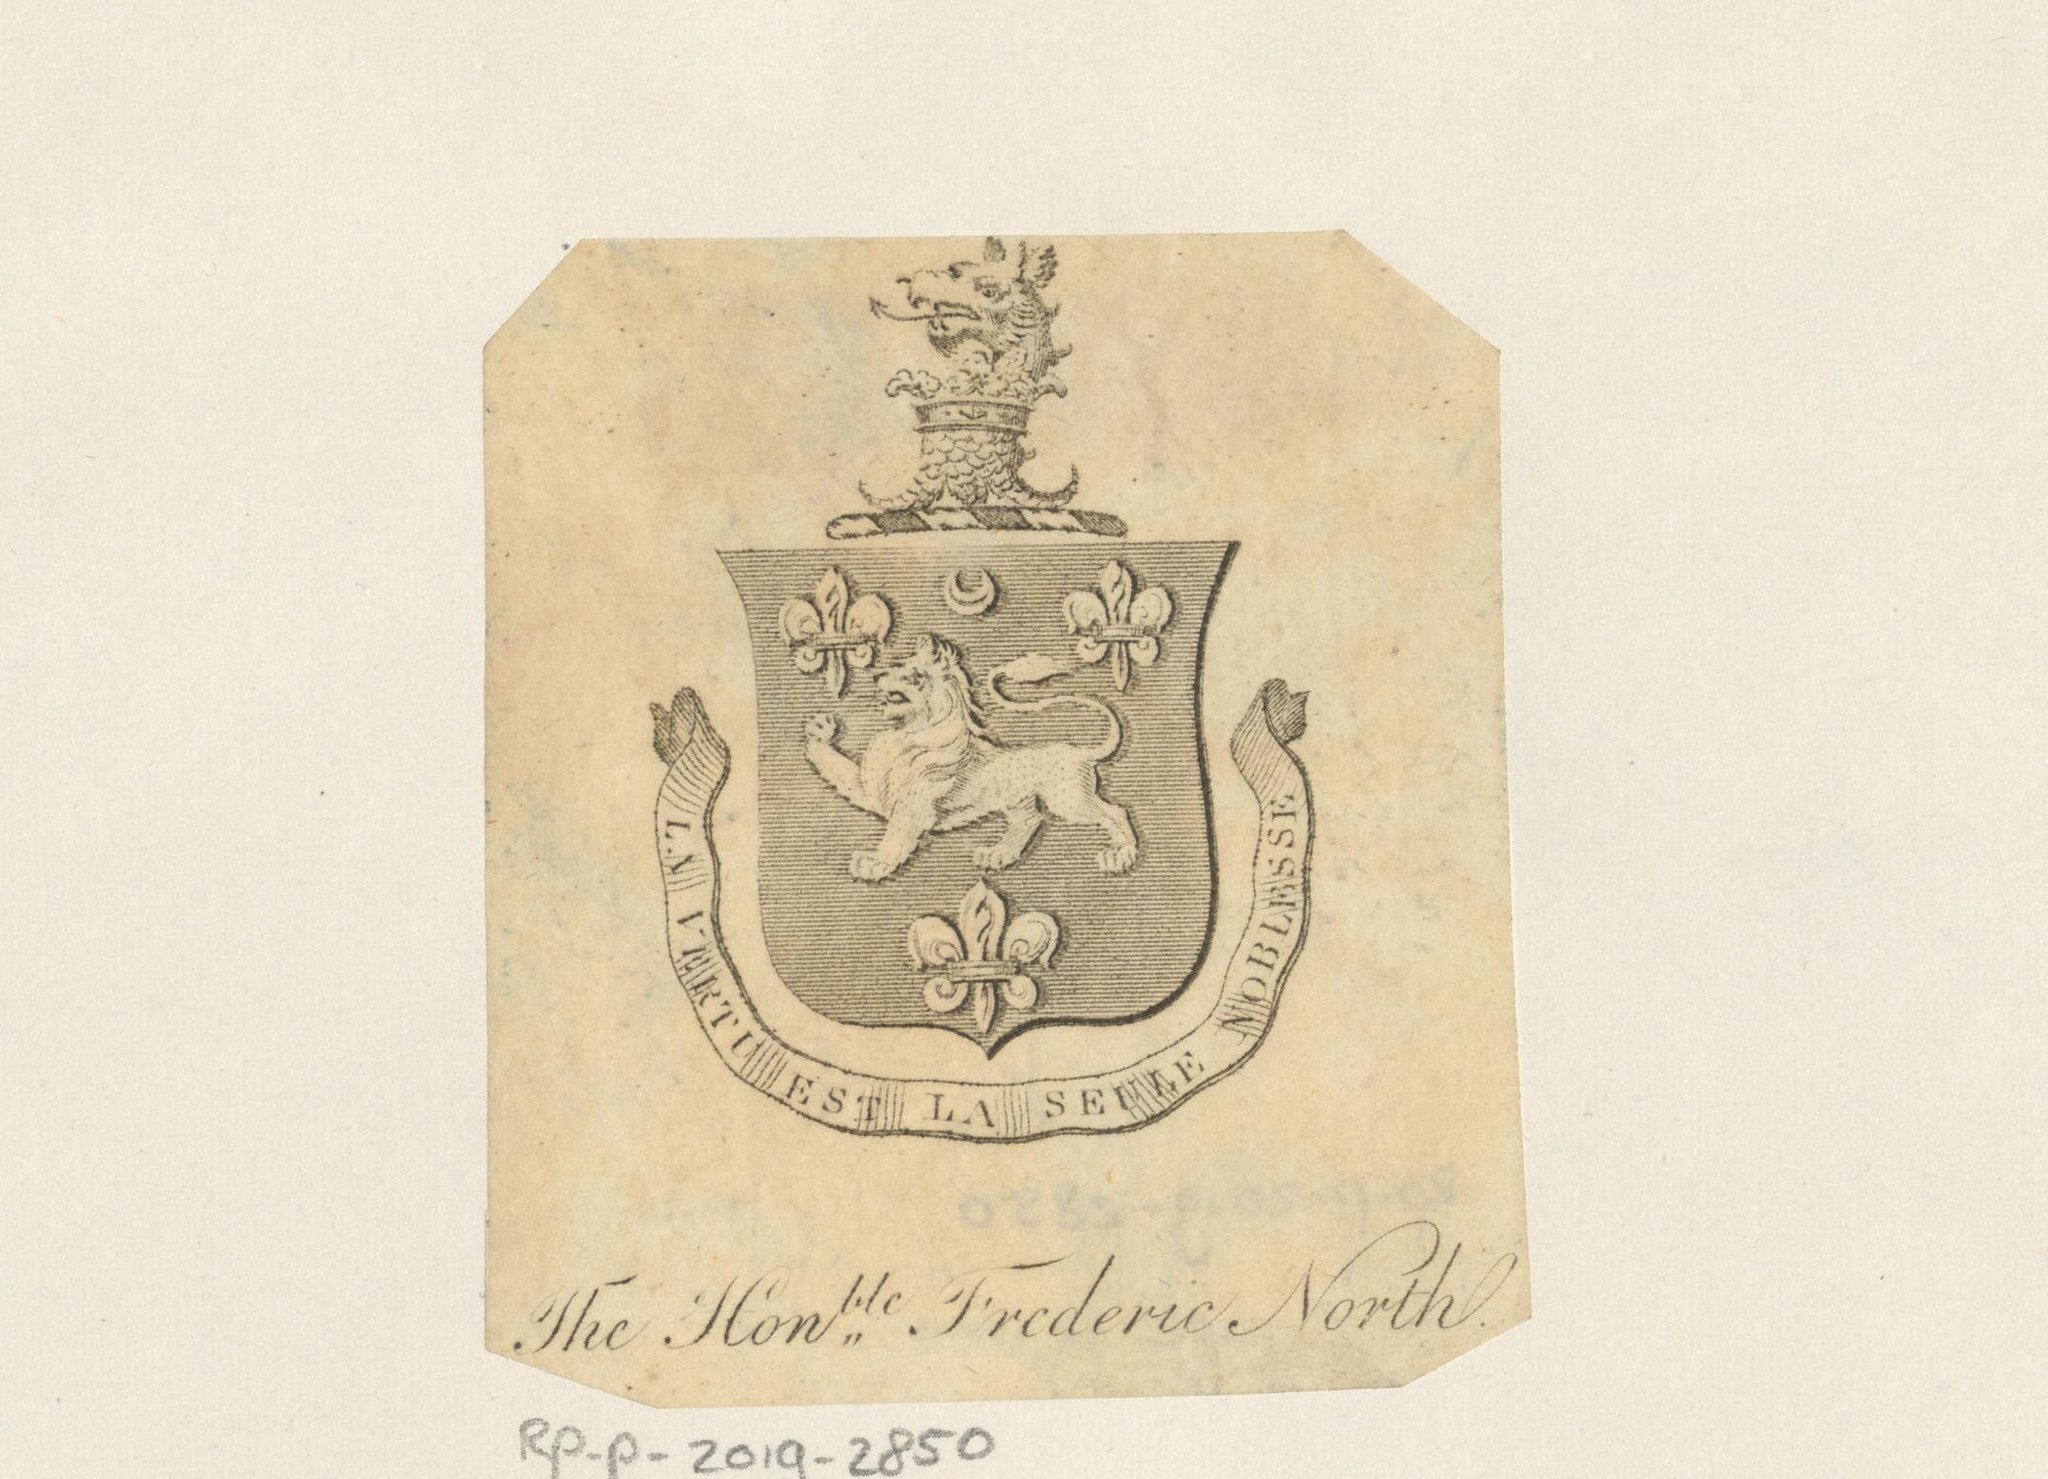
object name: bookplate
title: La vertu est la seule noblesse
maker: Anonymous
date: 1742-1792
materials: paper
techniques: engraving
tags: armorial bearing, heraldry